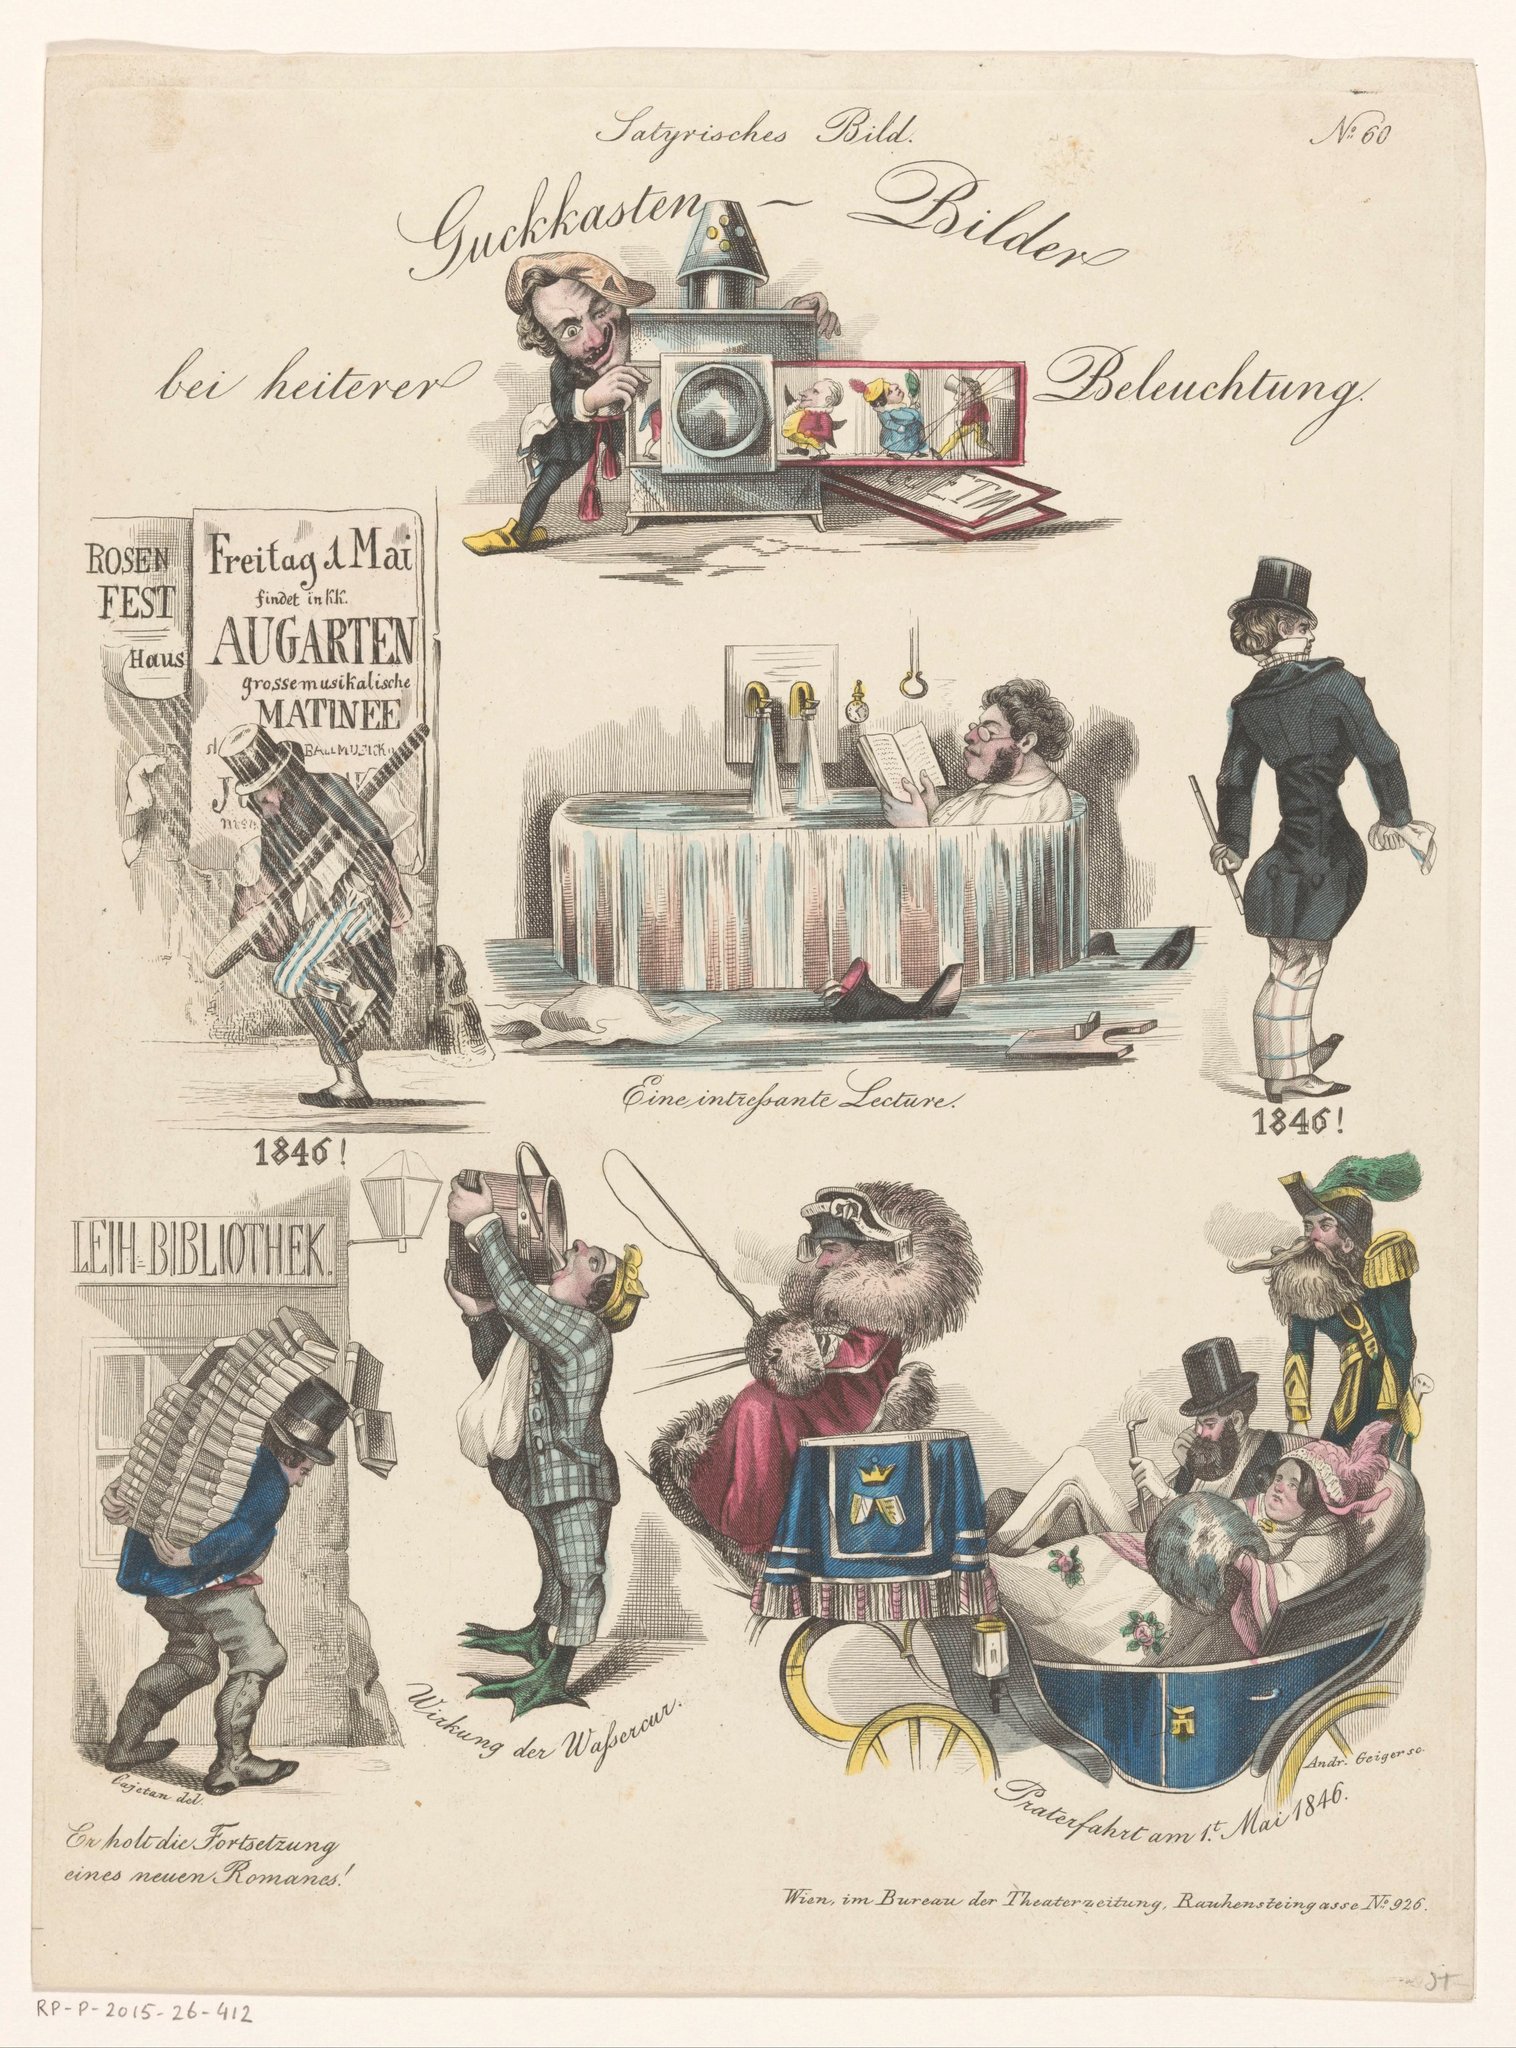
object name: print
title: Satyrisches Bild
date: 1846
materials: paper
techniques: engraving, etching, hand coloring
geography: vienna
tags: taking a bath, reading, magic lantern, four-wheeled, animal-drawn vehicle, e.g.: cab, carriage, coach, book, watering-place, spa, public library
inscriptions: collector's mark: Lugt 2228, collector's mark: Lugt 4779, collector's mark: Lugt 4780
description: Prent gepubliceerd in: Wiener Allgemeine Theater-Zeitung. Wenen: A. Bäuerle, 1846.